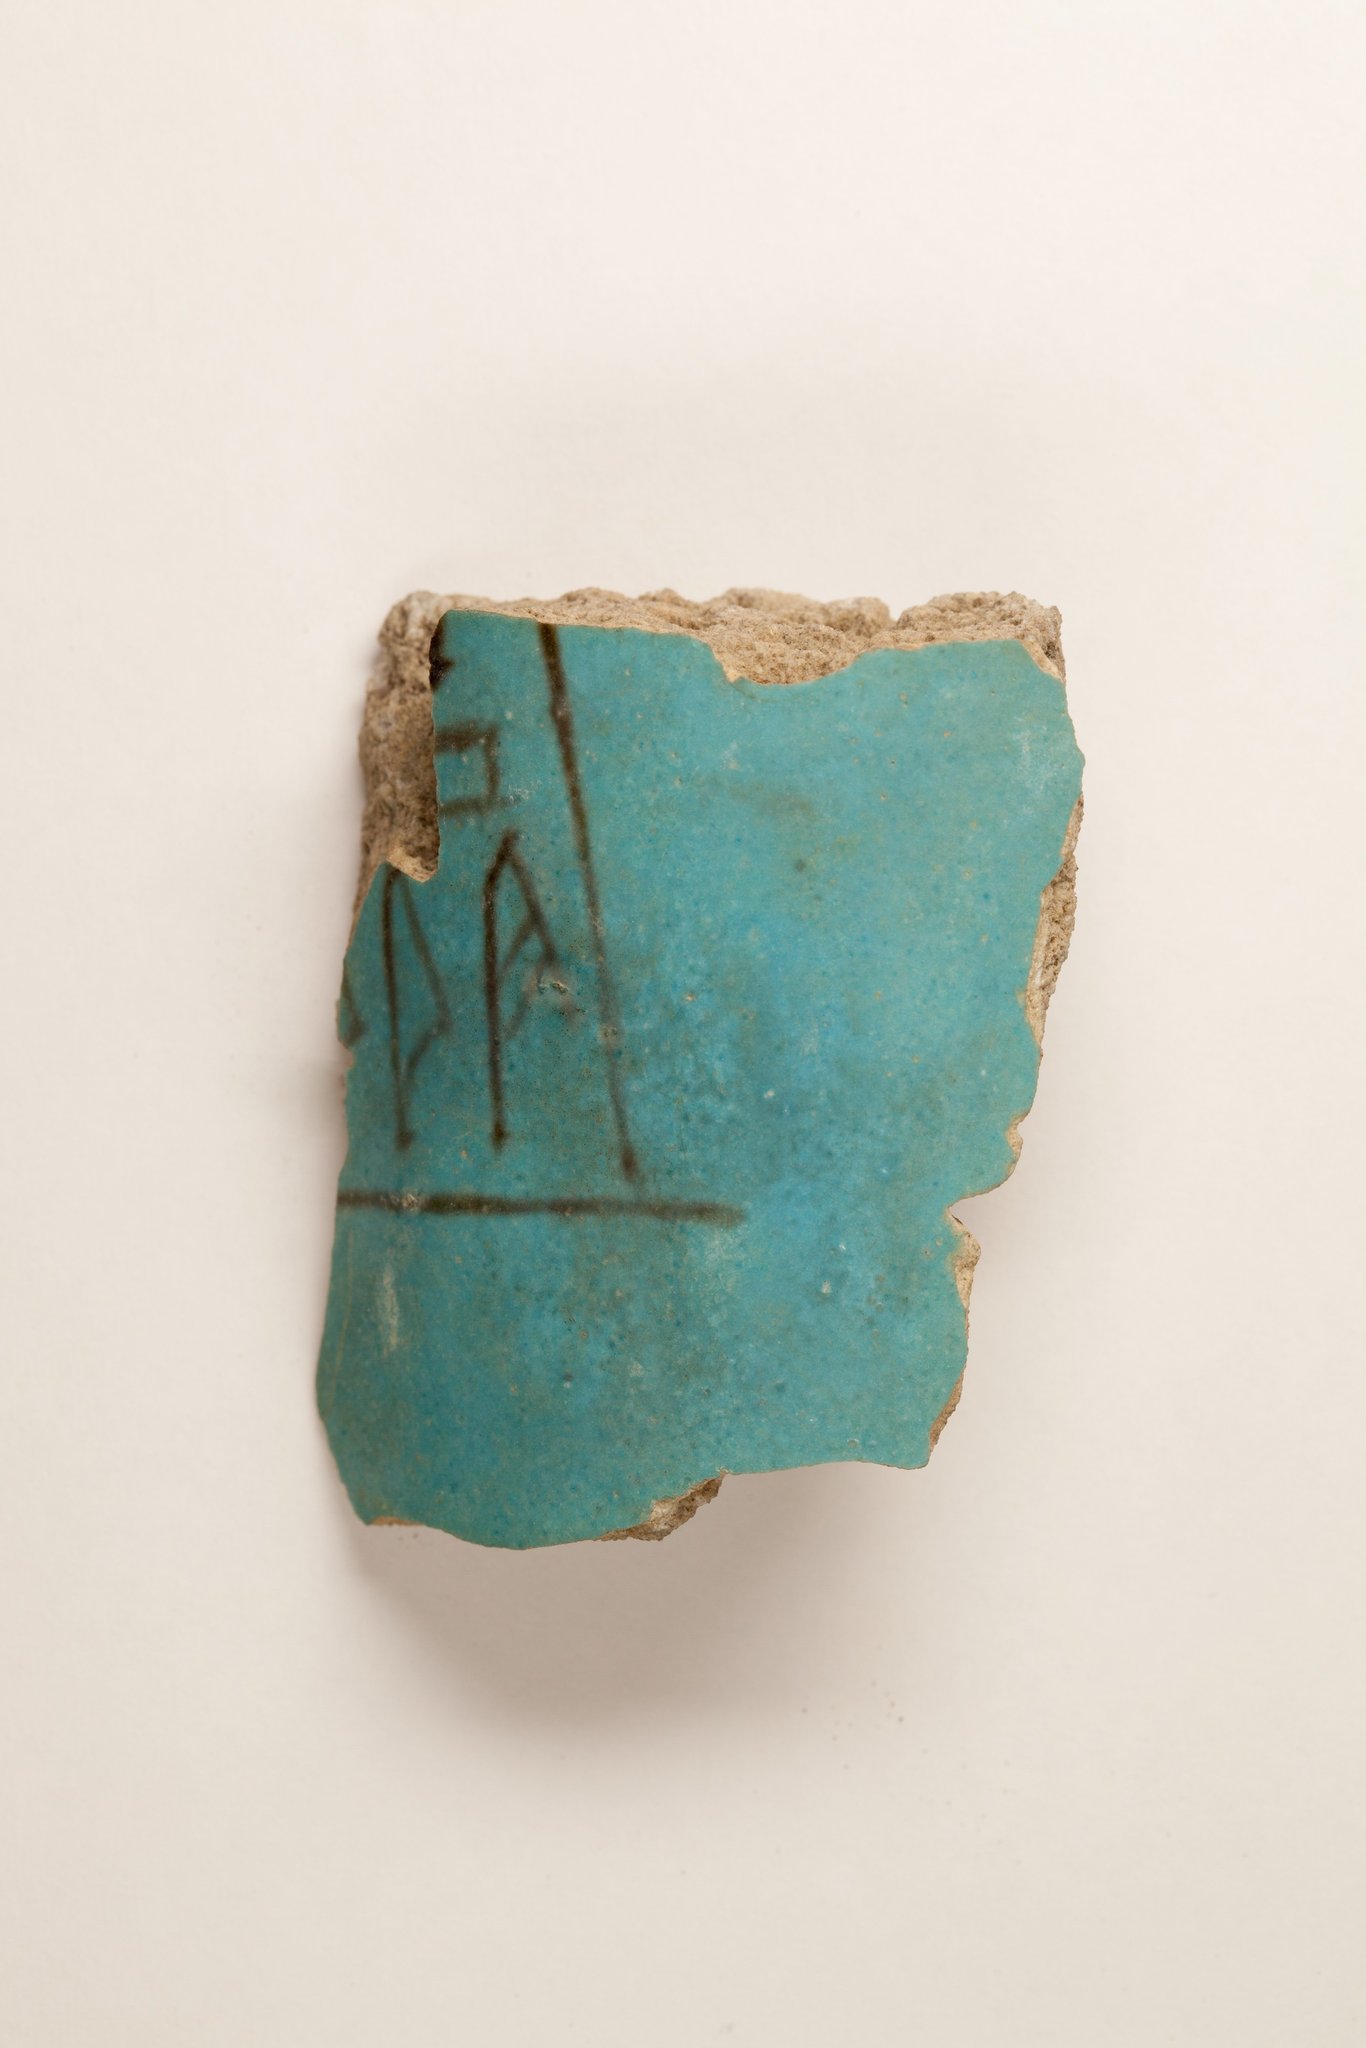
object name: vase fragment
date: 1981-1640 BCE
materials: faience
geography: egypt